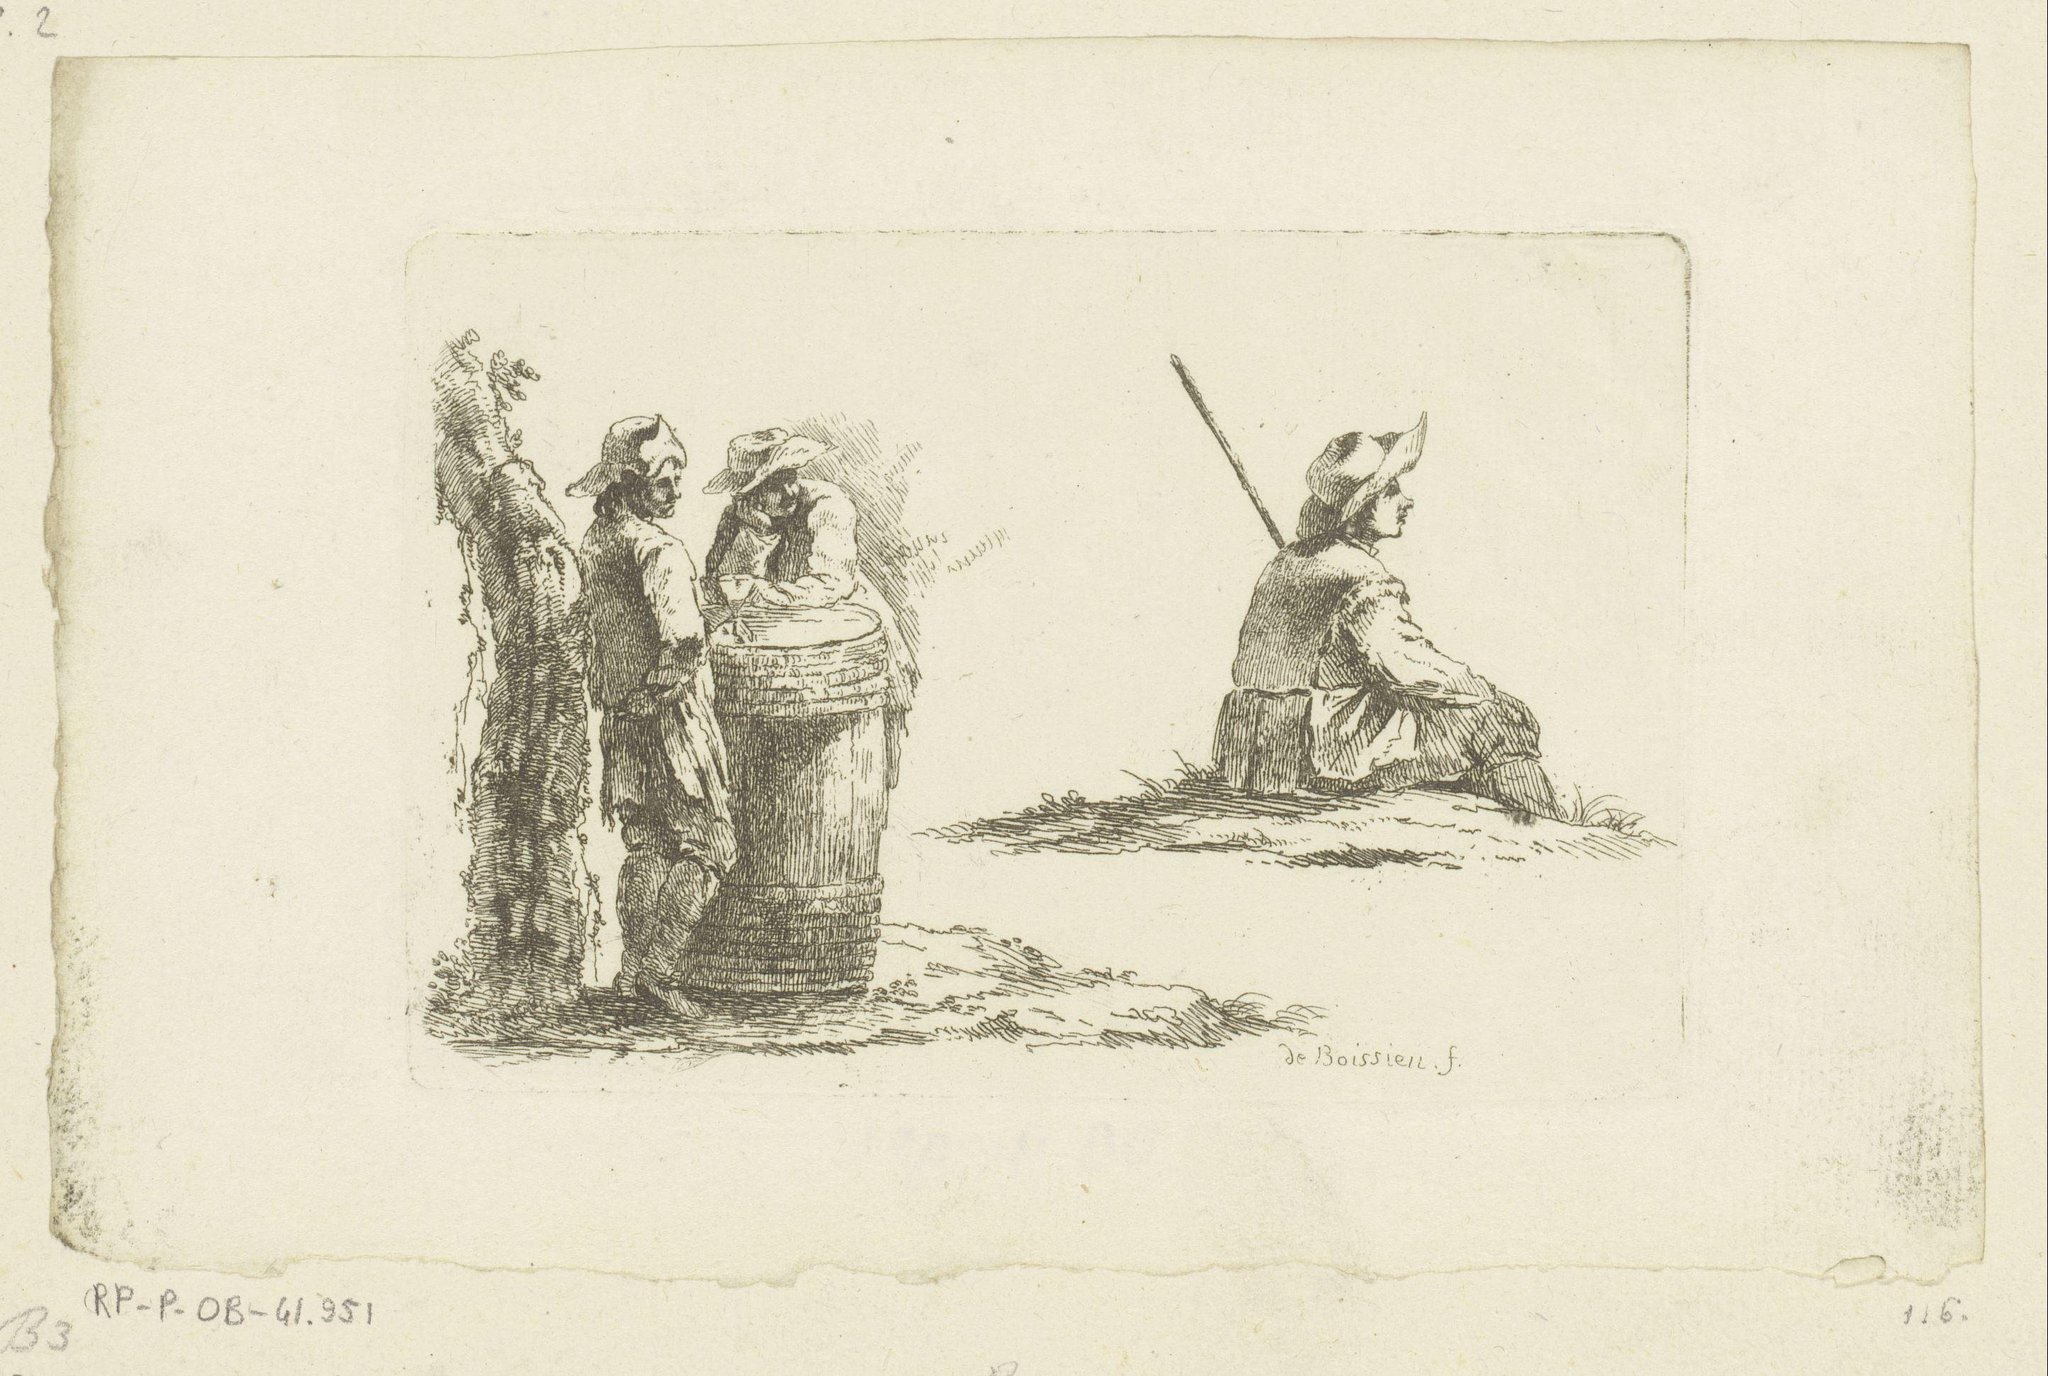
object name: print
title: Livre de griffonnements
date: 1758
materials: paper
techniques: etching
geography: france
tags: wooden container: barrel, cask, bucket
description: Maakt deel uit van een zesdelige serie getiteld 'Livre de griffonnements', uitgegeven in 1758 te Parijs bij Pariset.